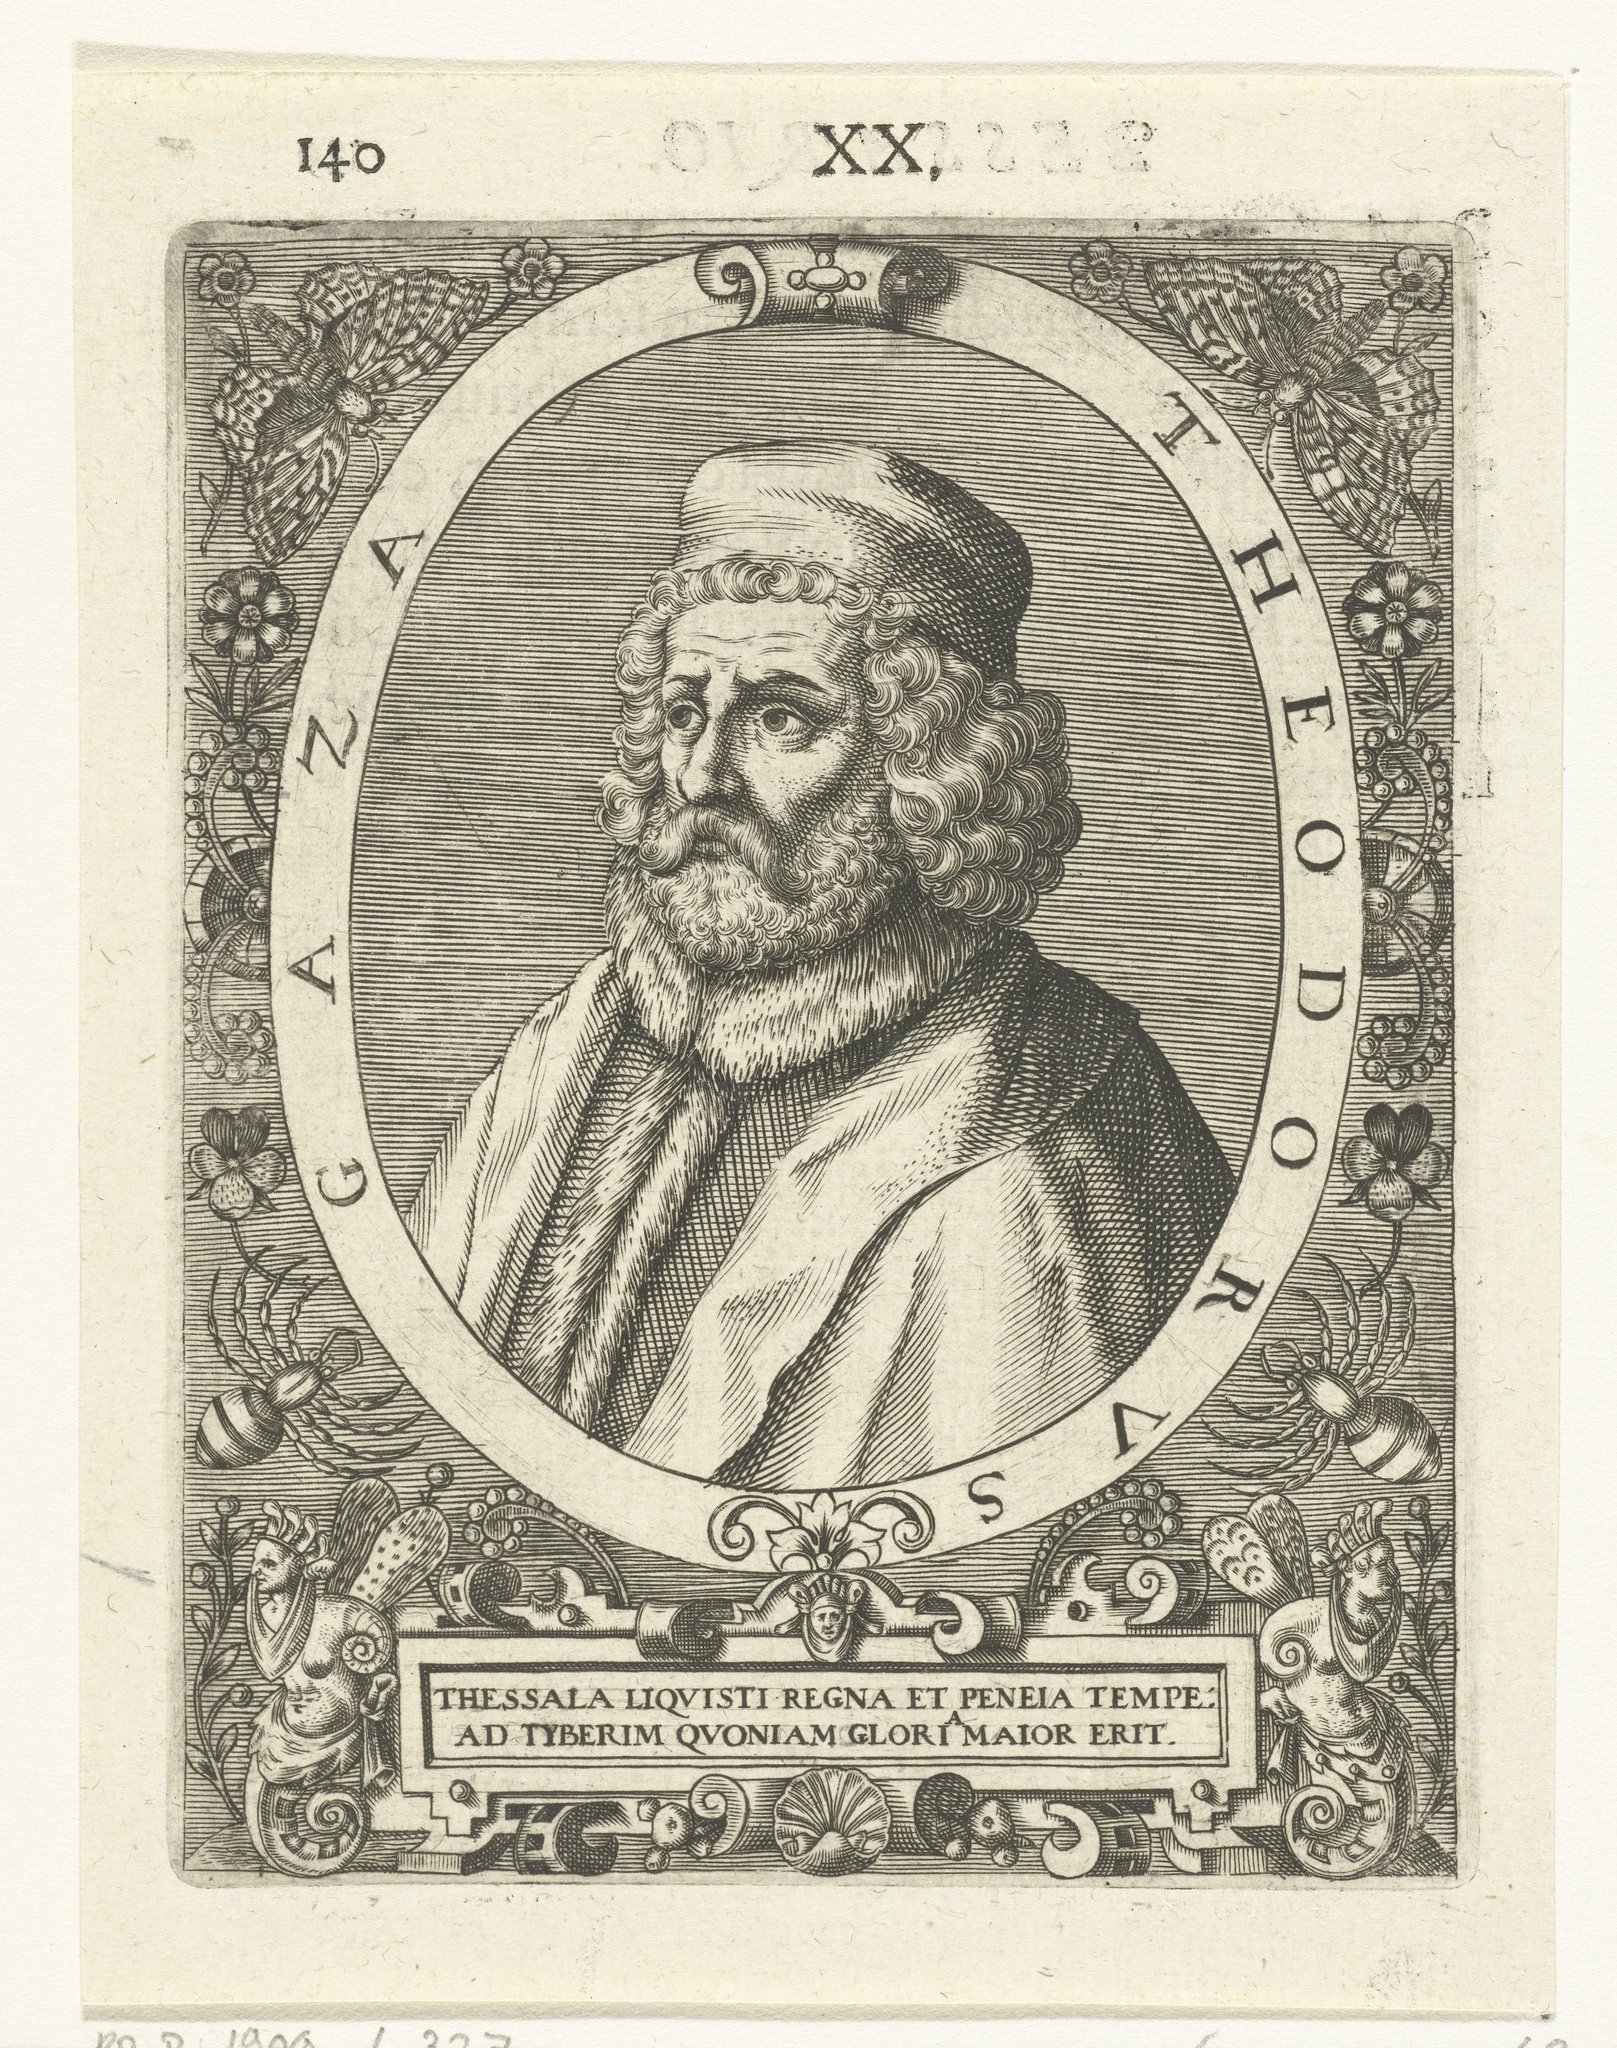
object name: print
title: Portret van Theodorus Gaza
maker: jean jacques boissard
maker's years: 1528-1598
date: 1597-1599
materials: paper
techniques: engraving, letterpress printing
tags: calabria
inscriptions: collector's mark: Lugt 2228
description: Gemaakt voor: J.J. Boissard, Icones virorum illustrium doctrina &c eruditione praestanti um contines. Frankfurt am Main: de Bry, 1597-1599.